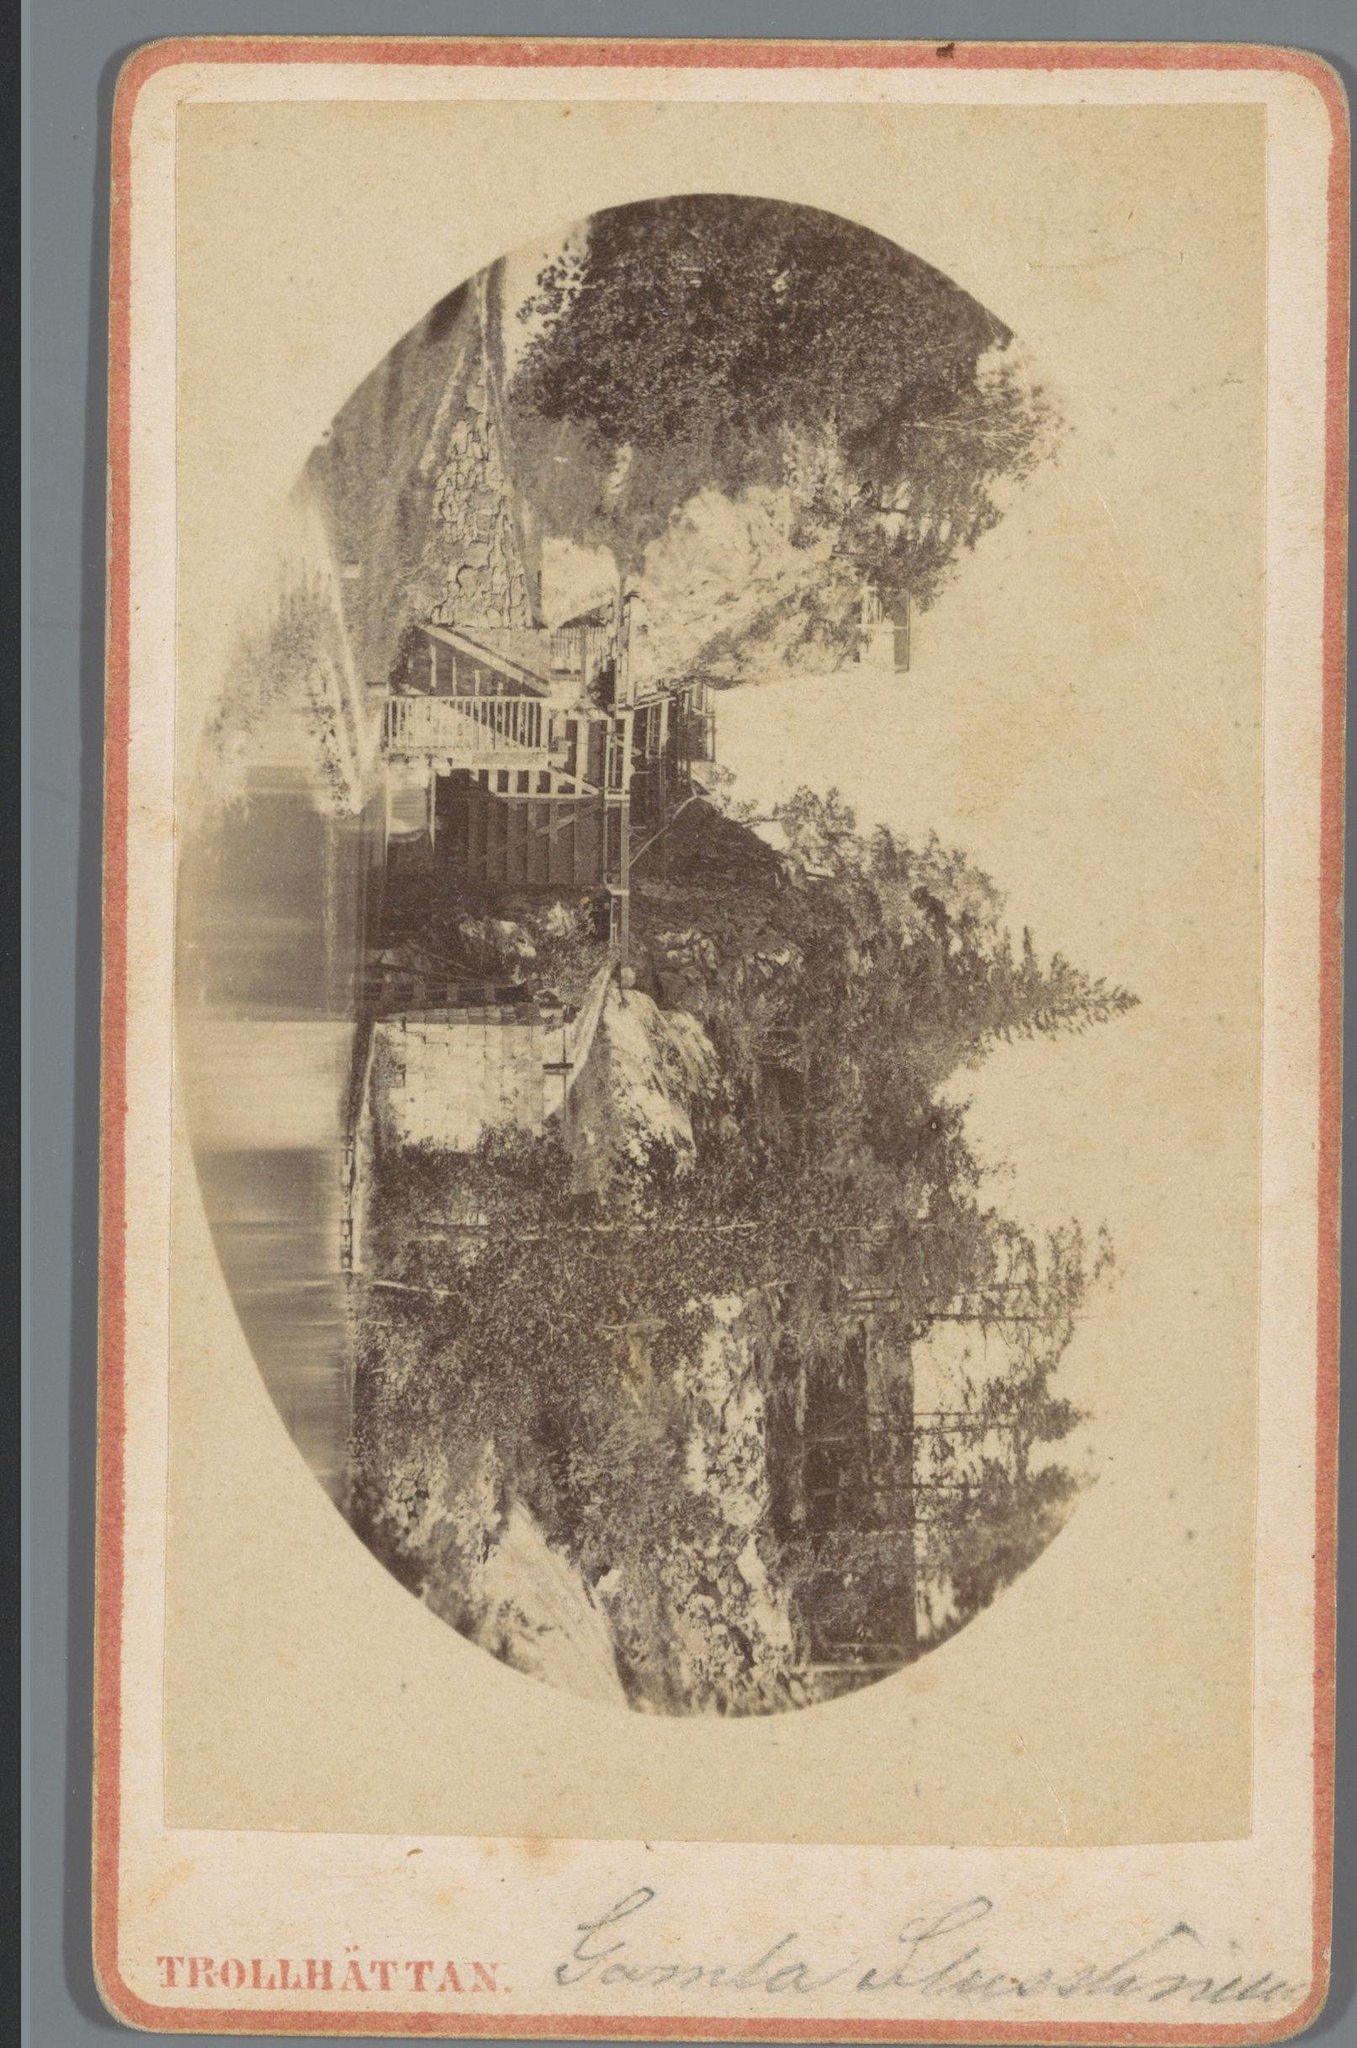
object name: photograph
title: Trollhättan. Gamla Slussleder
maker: robert dahllöf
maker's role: publisher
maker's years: 1842-1904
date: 1872-1876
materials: cardboard, paper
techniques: albumen print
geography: trollhättan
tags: sluice, weir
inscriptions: inscription: ‘Trollhätan’, inscription: ‘Trollhättan’, inscription: ‘Fotografi/ af/ Robert Dahllöf/ Göteborg./ Pabeställning utföres fotografier at Eigendommar./ Fartyf, Machinerier m.m.’